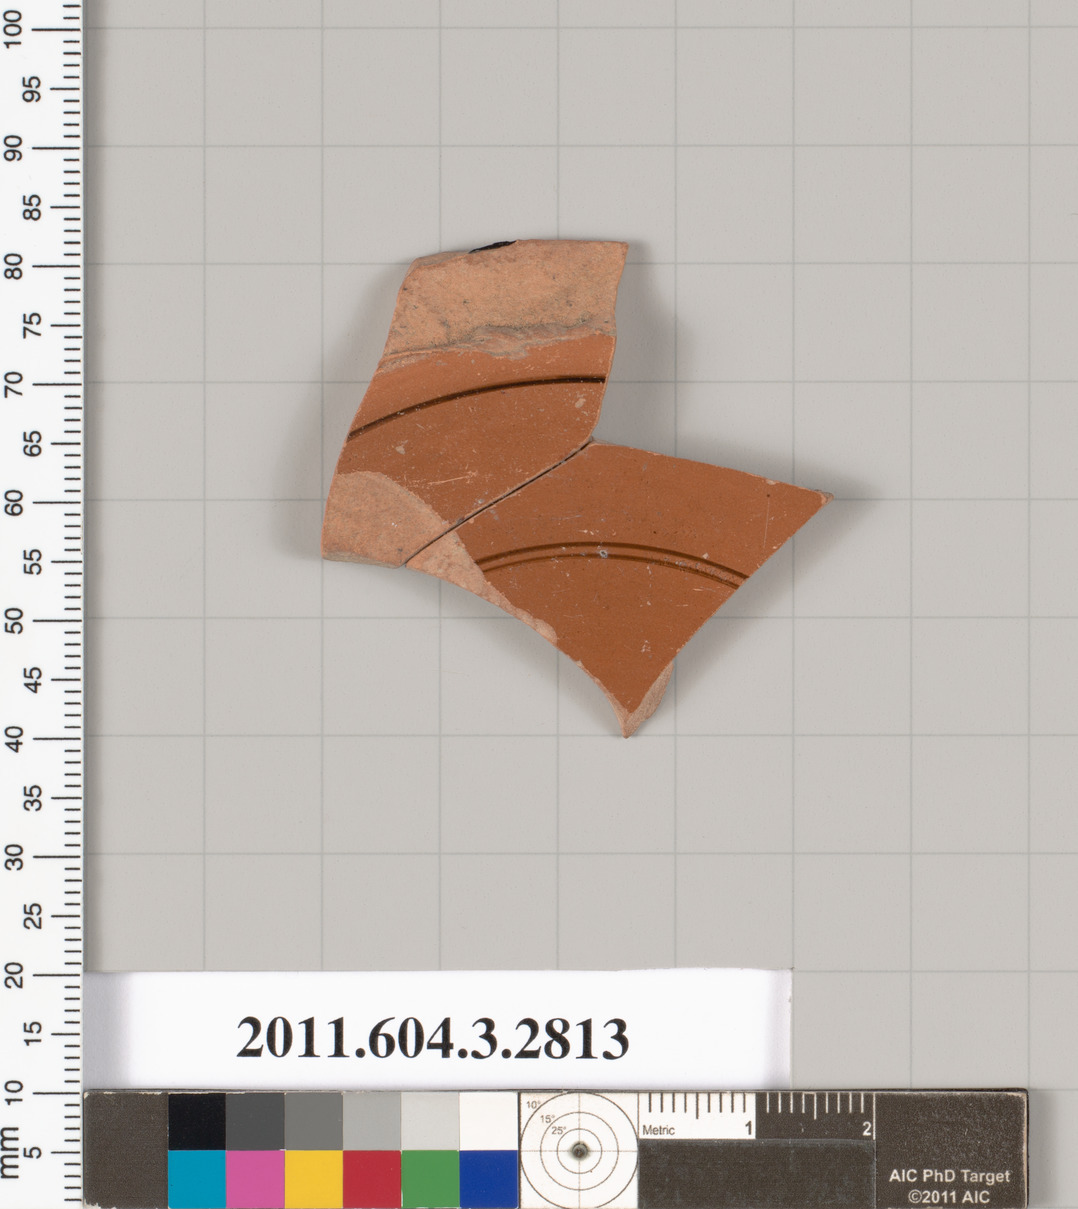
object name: kylix fragment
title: Terracotta fragment of a kylix (cup)?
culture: greek, attic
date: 600-401 BCE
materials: terracotta